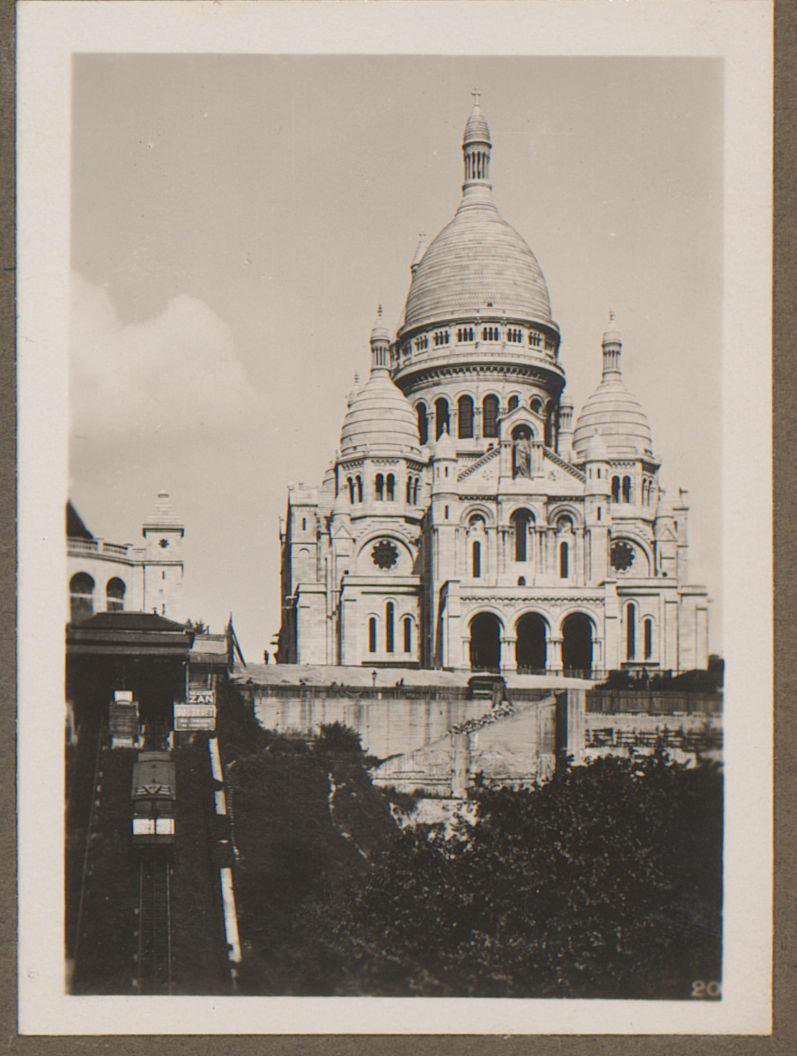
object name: album leaf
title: Gezicht op de Sacré-Coeur, Parijs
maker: Anonymous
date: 1928-1933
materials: paper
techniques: gelatin silver print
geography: paris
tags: church (exterior)